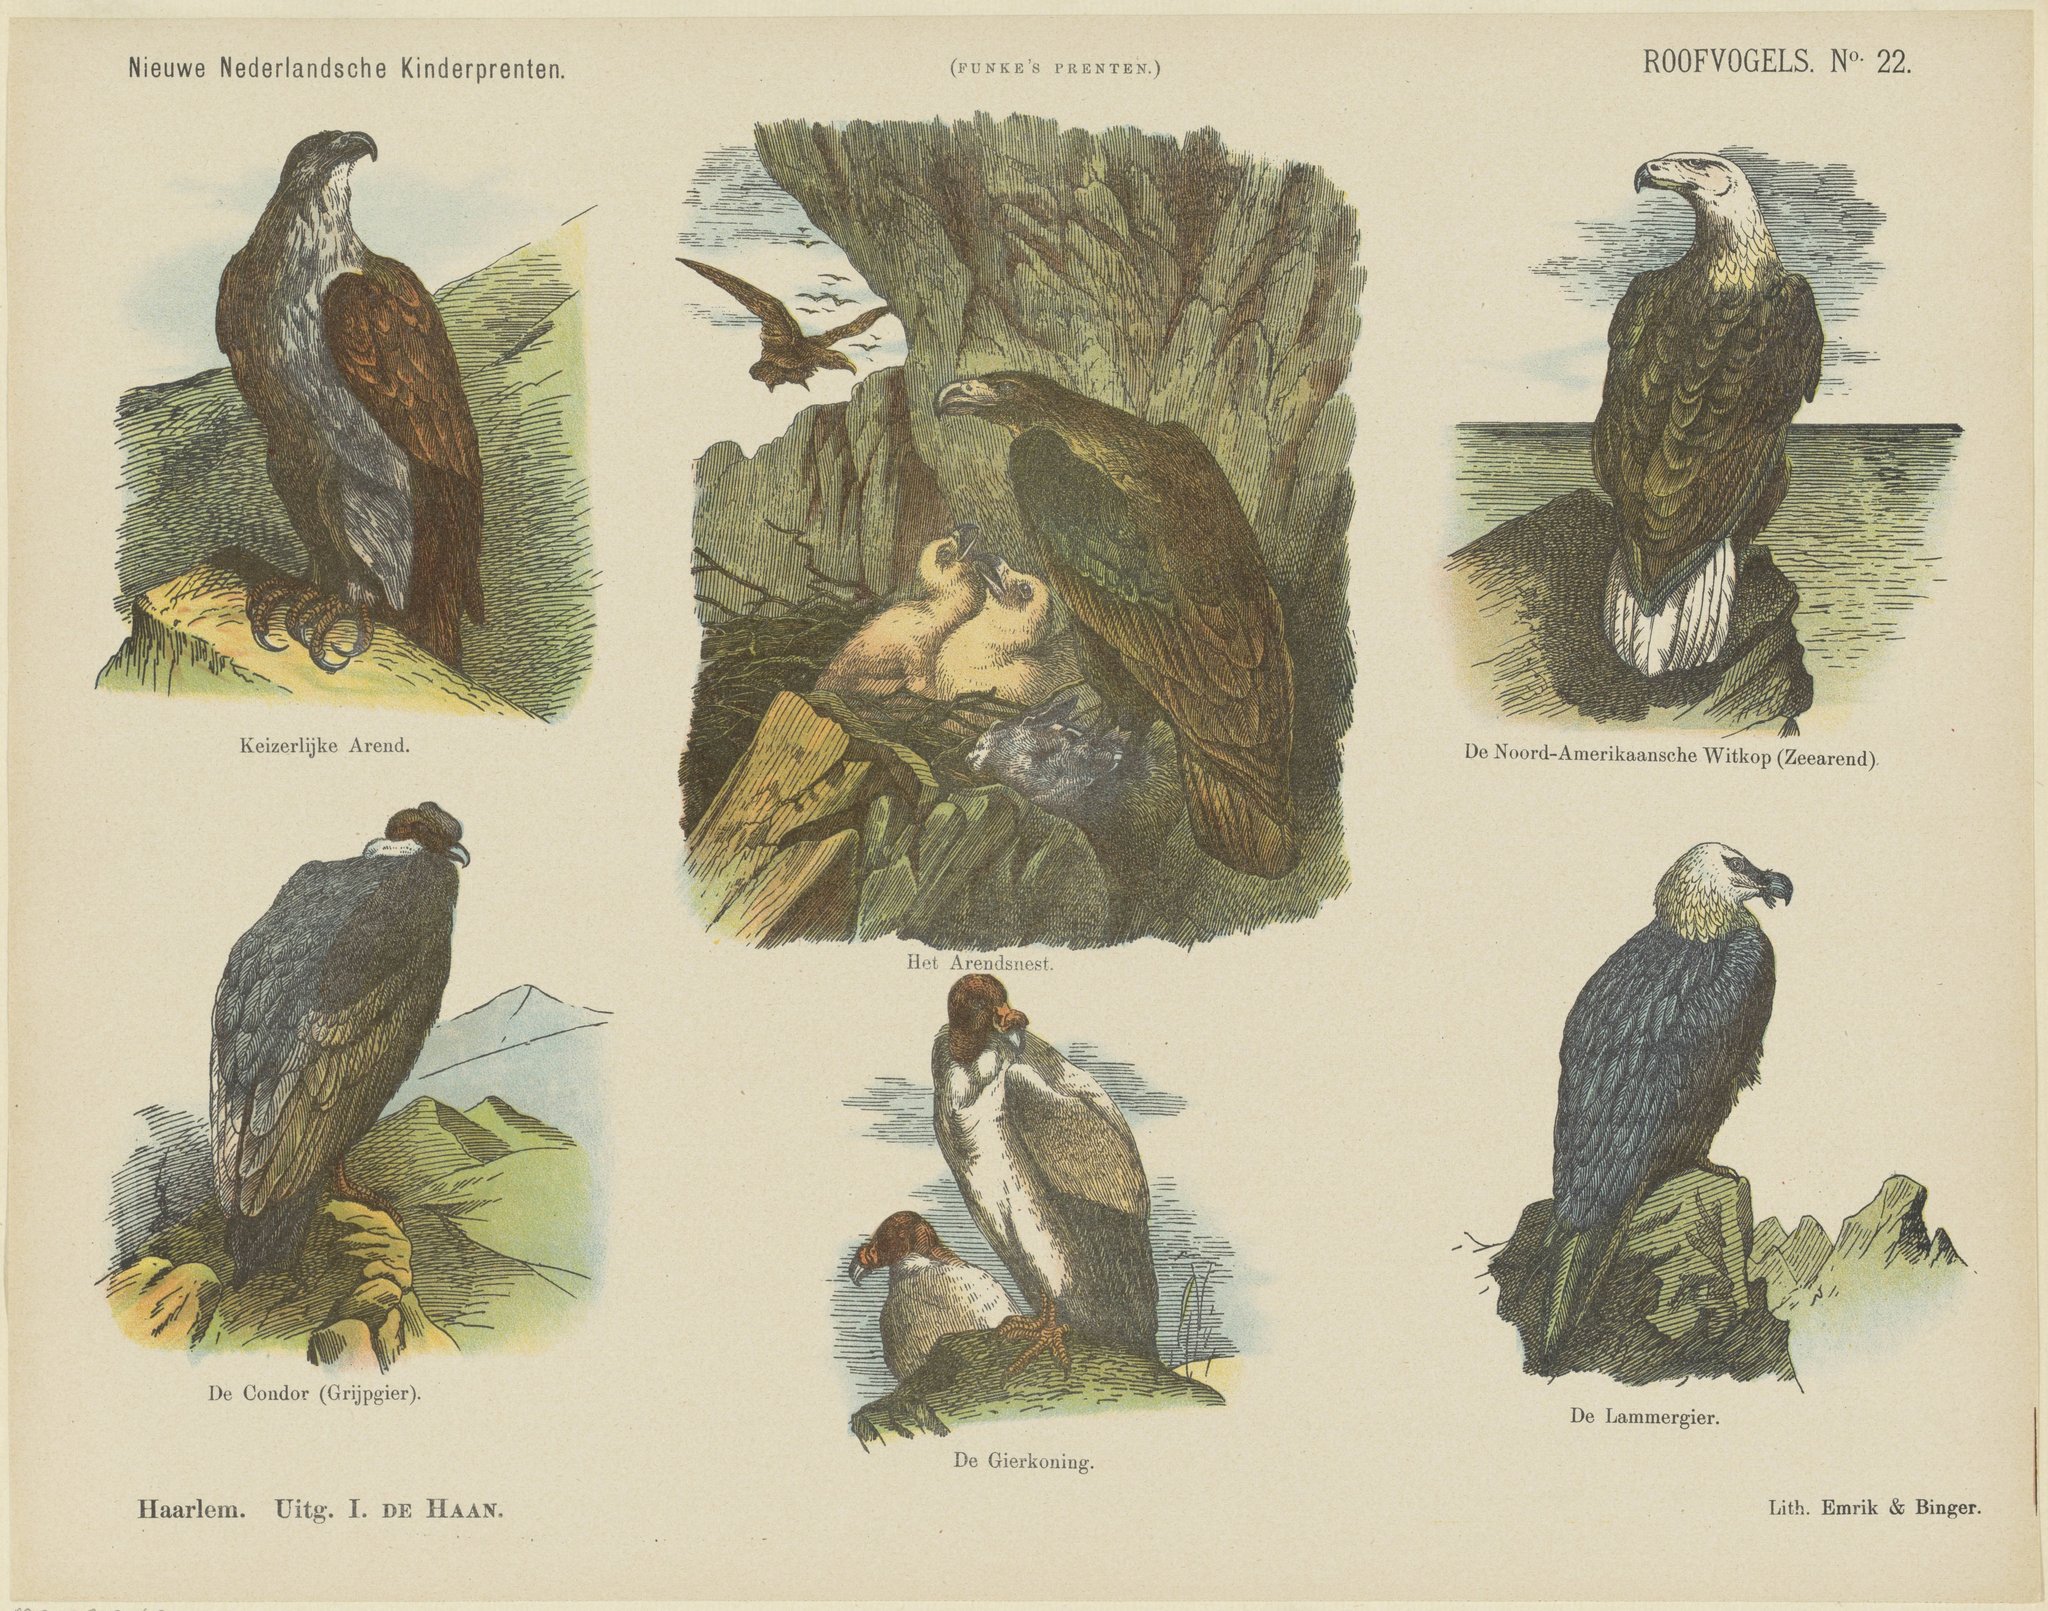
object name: popular print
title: Nieuwe Nederlandsche kinderprenten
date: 1875-1903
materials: paper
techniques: lithograph, letterpress printing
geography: haarlem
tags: predatory birds: eagle, predatory birds, predatory birds: vulture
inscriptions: collector's mark: Lugt 2760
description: Blad met 6 voorstellingen van roofvogels, onder andere een arend, een condor en een lammergier. Onder elke afbeelding een onderschrift. Genummerd rechtsboven: No. 22.